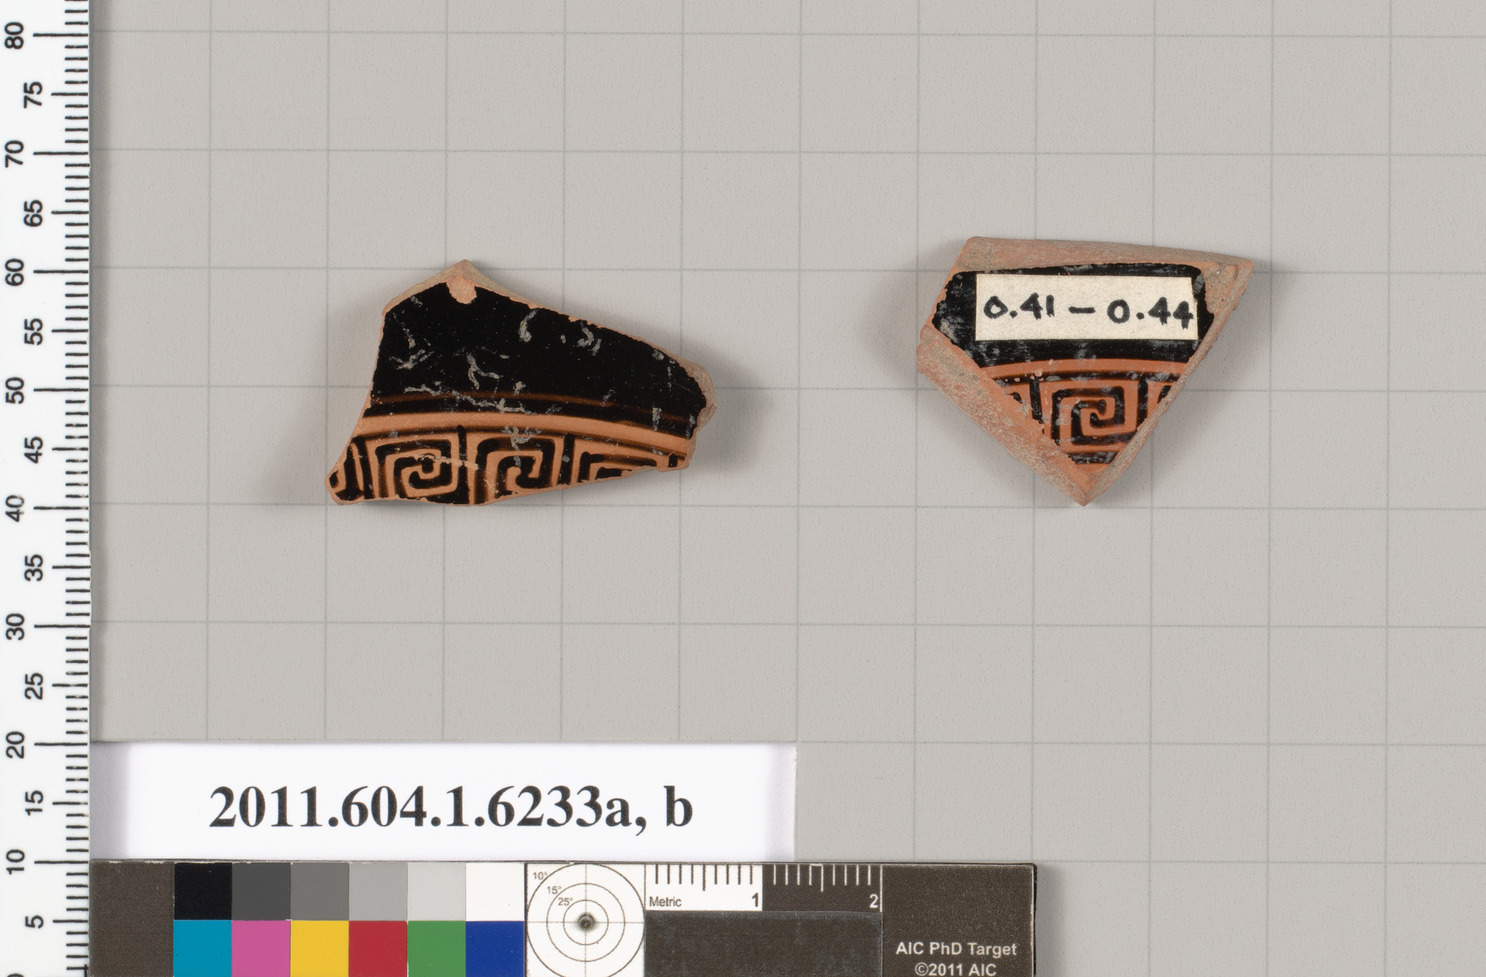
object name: kylix fragment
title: Terracotta fragments of kylikes (drinking cups)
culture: greek, attic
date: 500-480 BCE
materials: terracotta